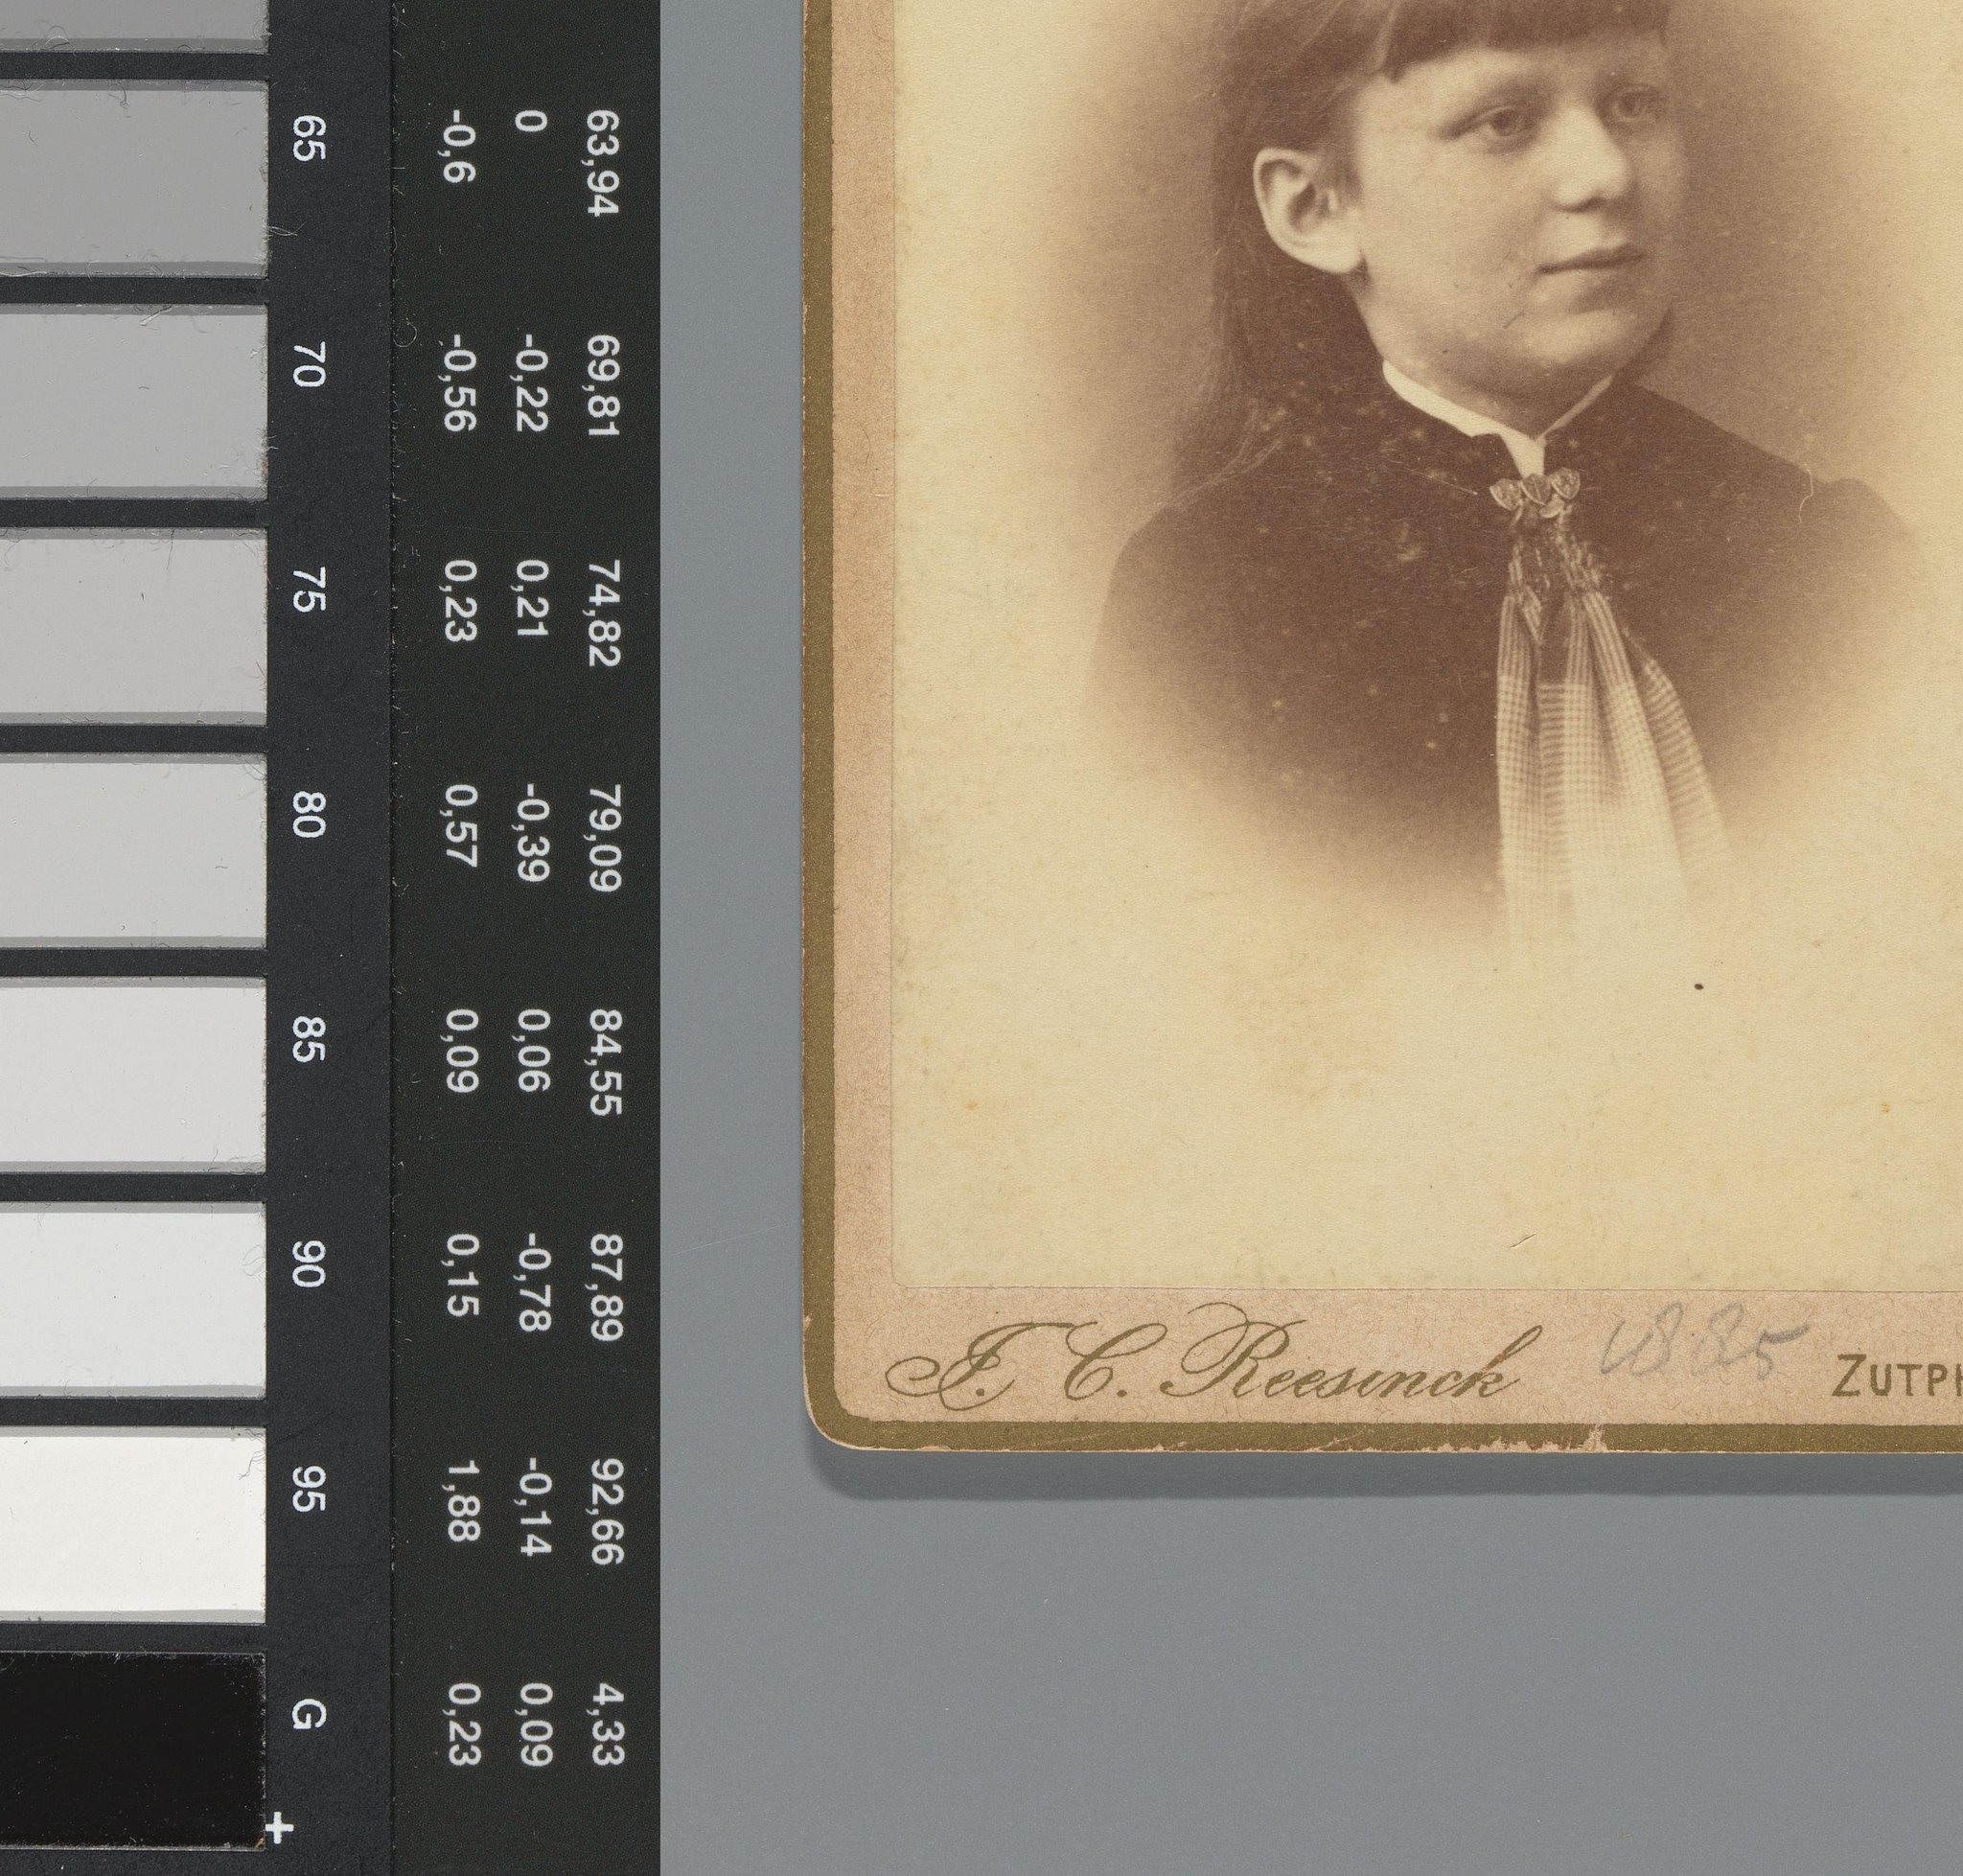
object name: carte de visite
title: Portret van Line van den Berg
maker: johan christiaan reesinck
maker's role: fotograaf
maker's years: 1838-1922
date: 1884-1885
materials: cardboard, photographic support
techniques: albumen print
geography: zutphen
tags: the hague, caroline louise van den berg-van den berg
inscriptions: inscription: ‘Line v.d. Berg’, date: ‘1884’, name: ‘J.C. REESINCK / ZUTPHEN / BERKELKADE B. 300. / Het cliché blijft voor nabestelling bewaard.’